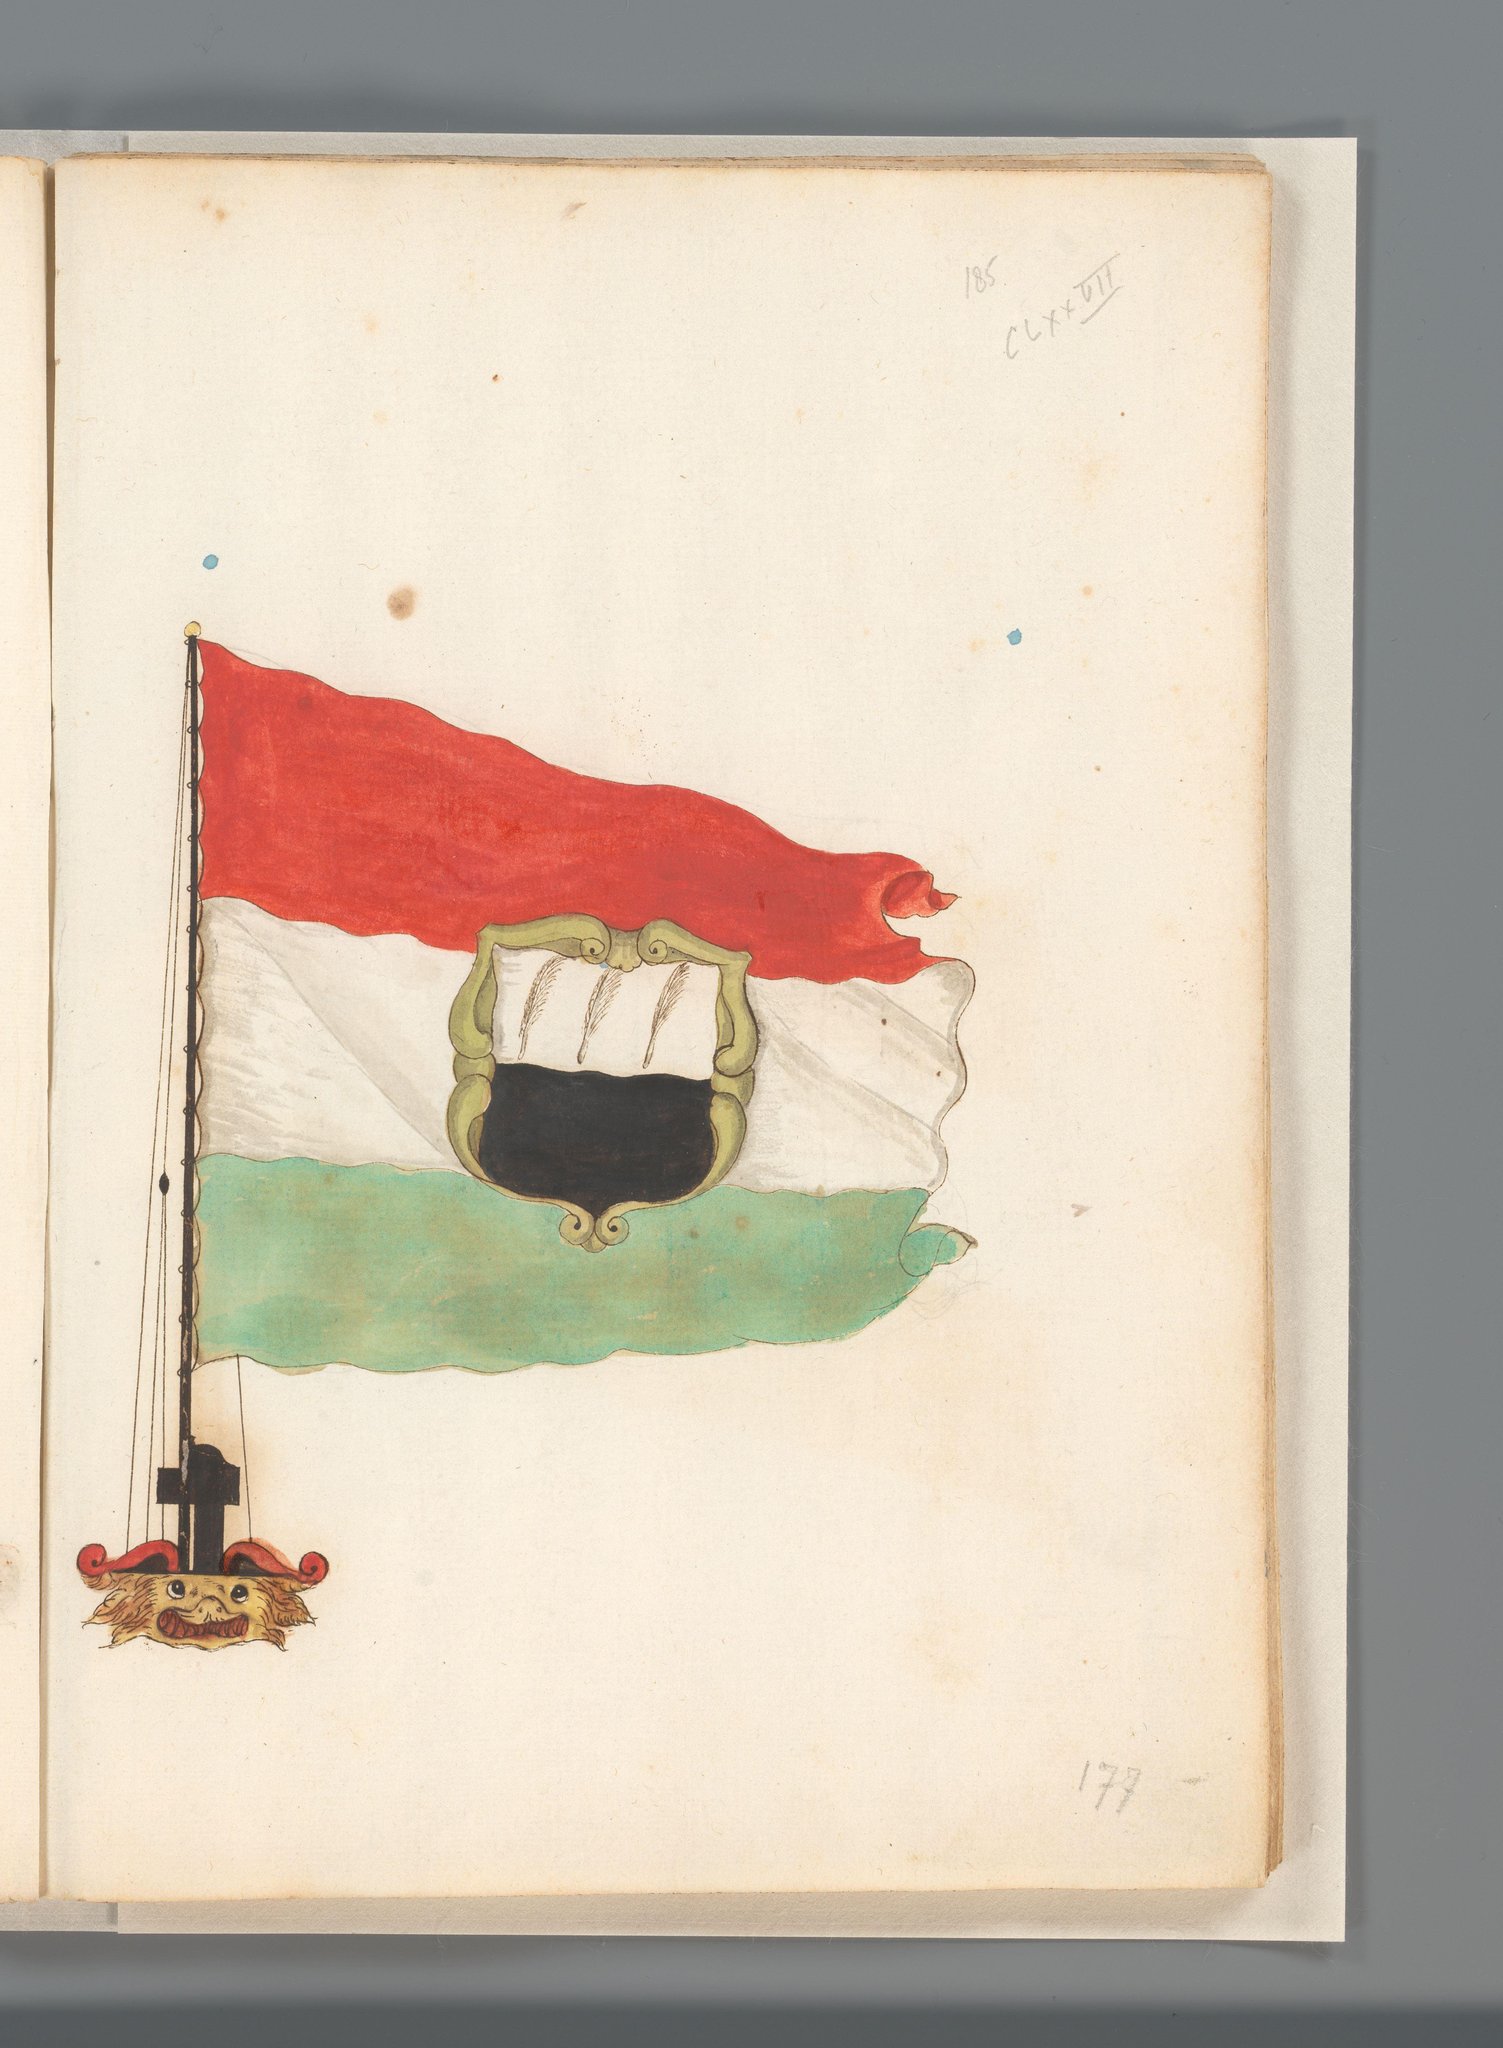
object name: drawing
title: Vlag van Joure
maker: Anonymous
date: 1667-1670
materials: ink, paper, watercolor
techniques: brush, pen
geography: france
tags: flag, colours (as symbol of the state, etc.)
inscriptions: number: ‘185 / CLXXVII / 177’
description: Vlag van de plaats Joure. Drie horizontale banen in rood, wit en blauw, met centraal hierop een horizontaal gebalkt wapen met boven drie halmen haver op een wit veld en onder een zwart veld, het wapen gevat in een cartouche. Vlag op vlaggensteng en mastvoet. Afgebeeld op folio 89r. Onderdeel van een vlaggenboek met vlaggen uit Europa, Noord-Afrika, Nabije en Verre Oosten.